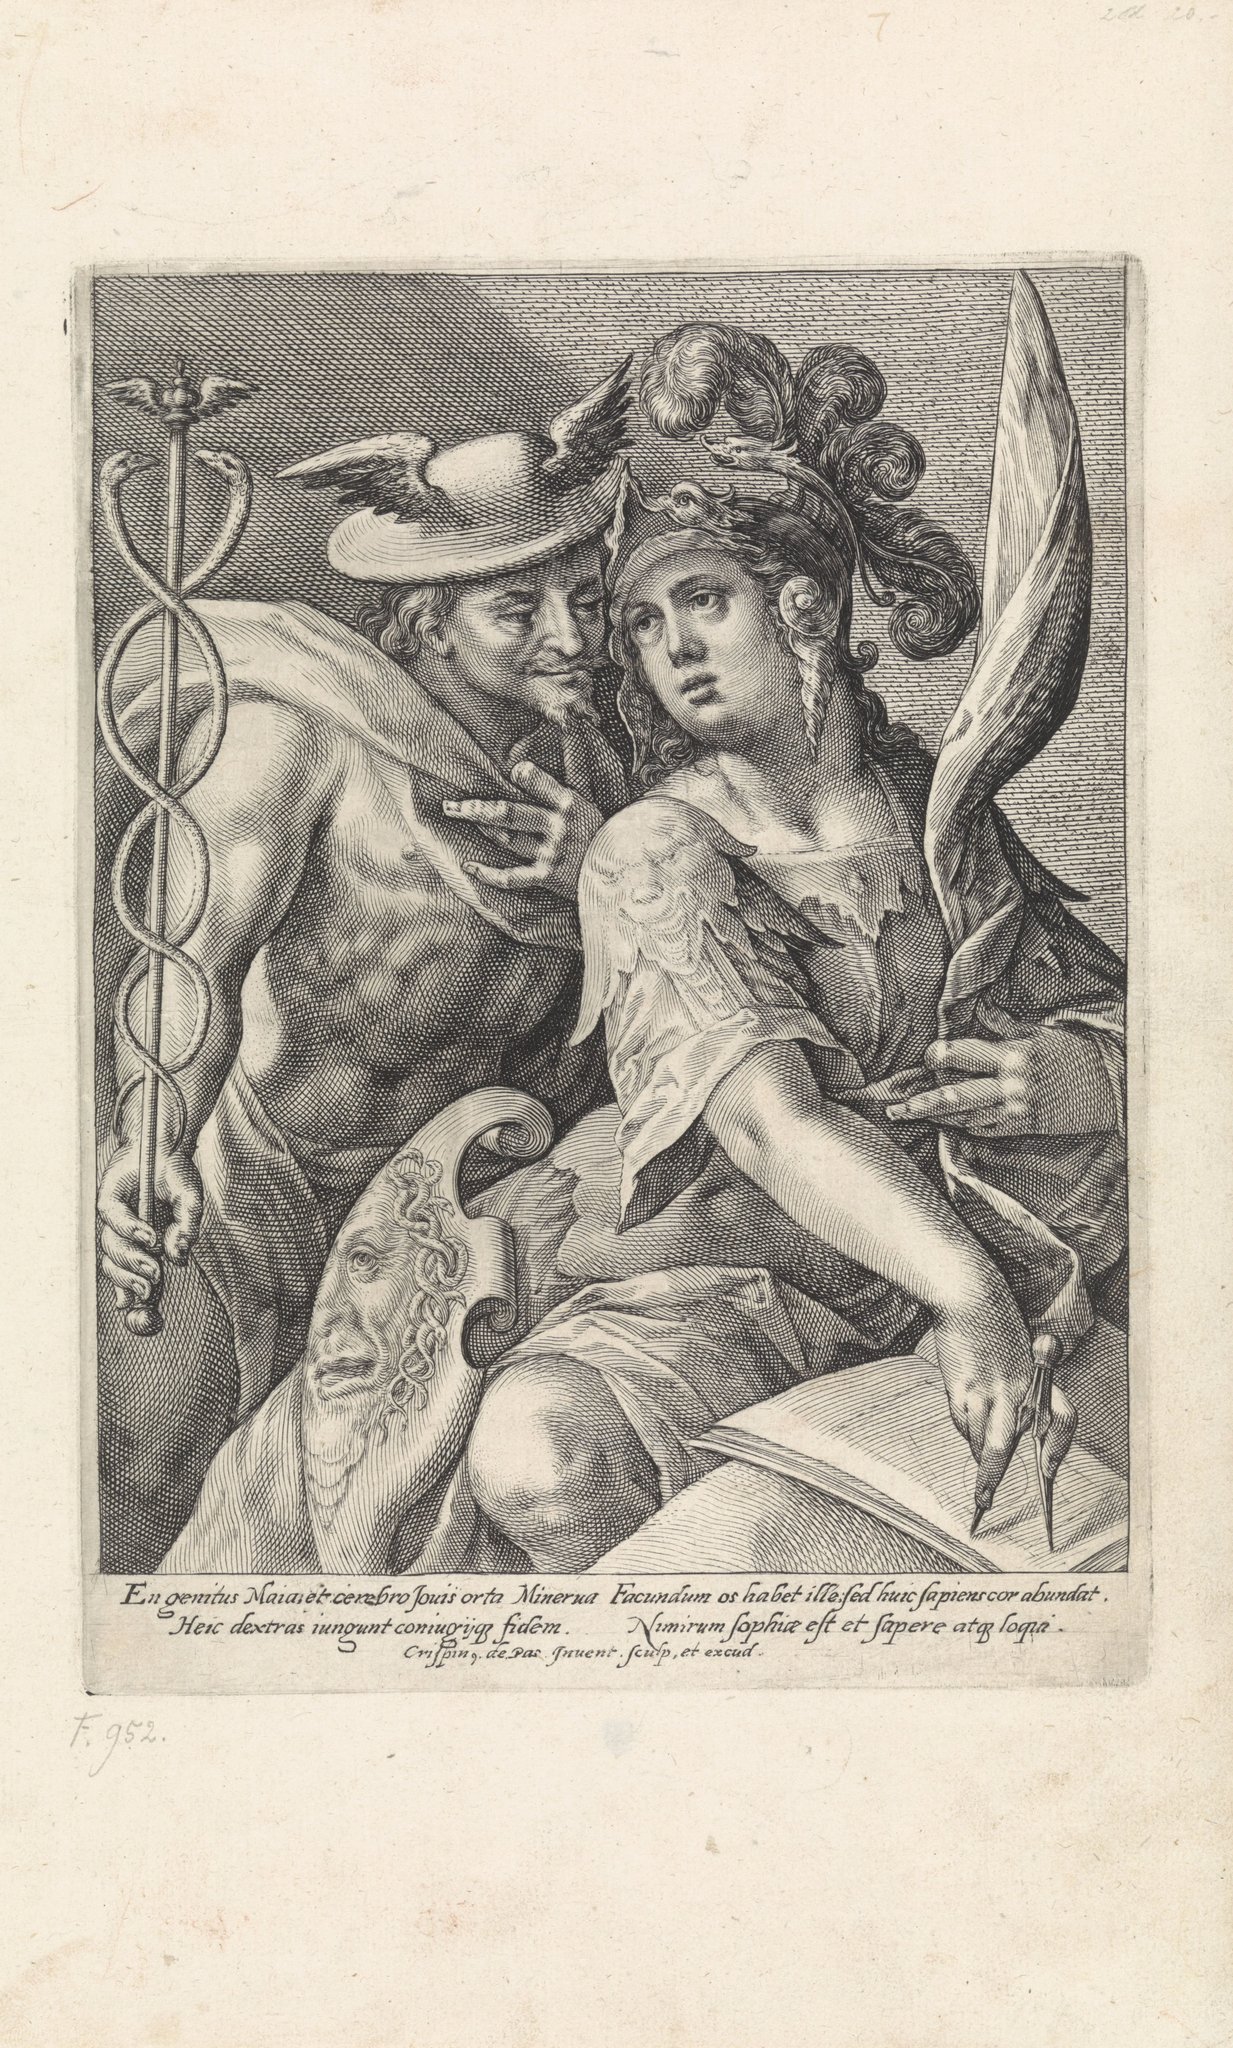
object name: print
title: Goden en Godinnen als geliefden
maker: crispijn van de passe (i)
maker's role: draughtsman, print maker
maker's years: 1564-1637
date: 1589-1611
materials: paper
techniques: engraving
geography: cologne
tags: (story of) minerva (pallas, athena), (story of) mercury (hermes)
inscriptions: number: ‘7’, collector's mark: Lugt 2760, collector's mark: Lugt 2228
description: Mercurius en Minerva als geliefden. Mercurius draagt zijn gevleugelde helm de petasus. In zijn hand houdt hij de caduceus. Hij verklaart zijn liefde aan Minerva. Minerva draagt een pluimhoed en tekent met een passer. In de marge een vierregelig onderschrift, in twee kolommen, in het Latijn, dat verwijst naar de geboorte van Minerva en haar wijsheid. Prent uit een serie met Goden en Godinnen als geliefden.